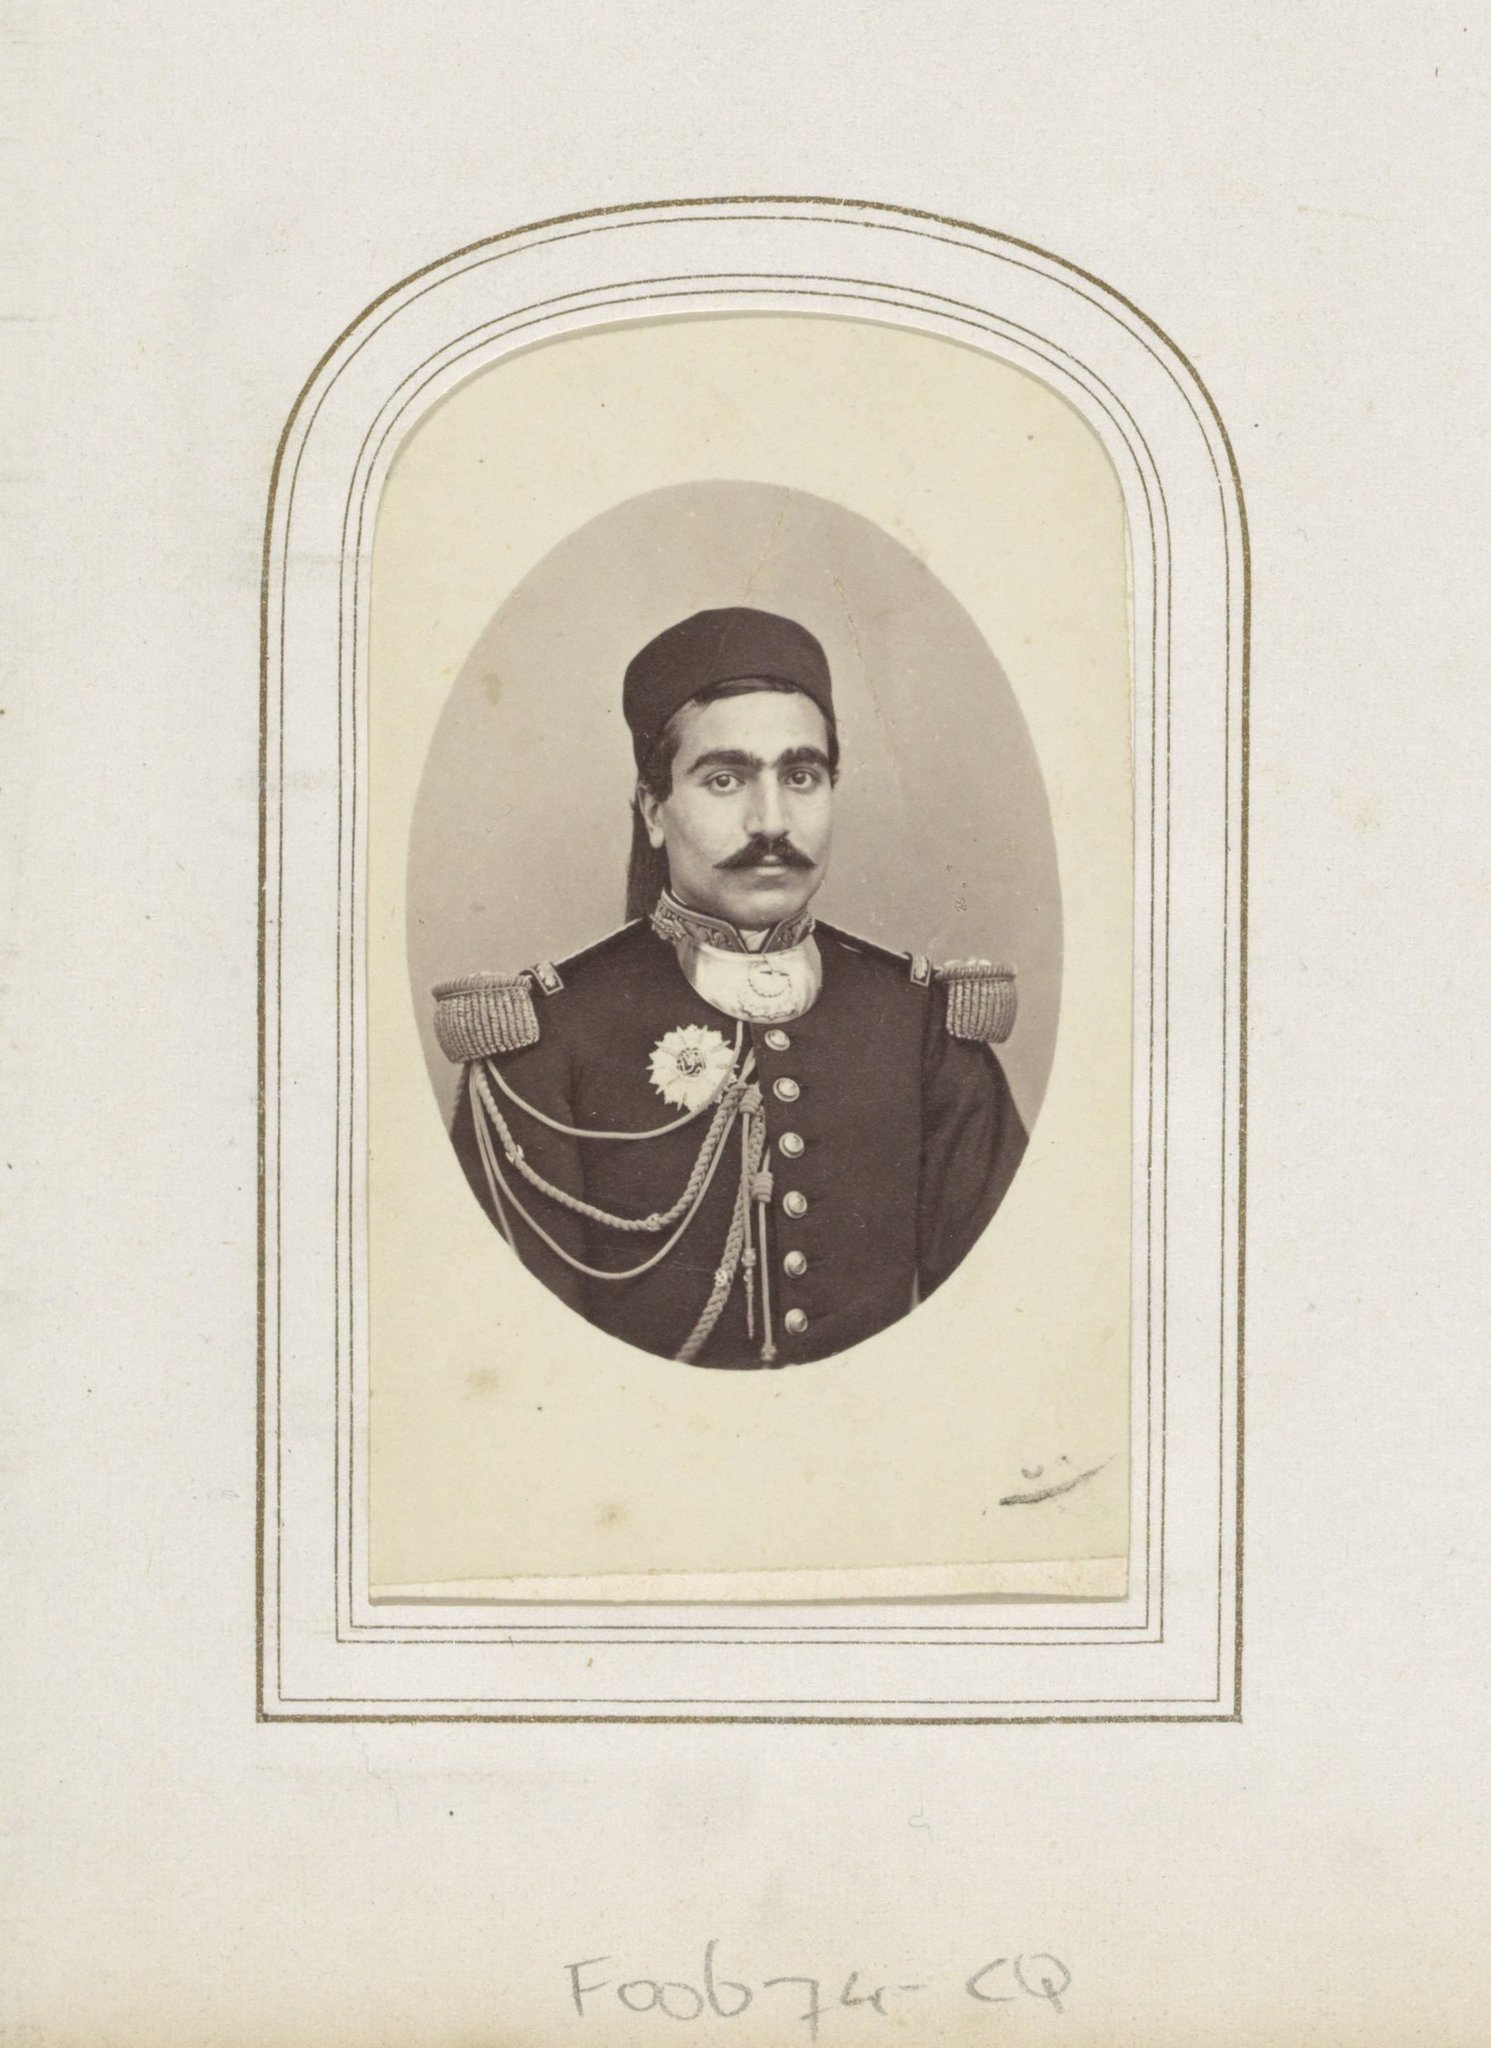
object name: carte de visite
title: Portret van Mustapha Ben Ismaïl, Tunesische generaal en minister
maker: Anonymous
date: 1875-1887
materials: cardboard, paper, photographic support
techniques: albumen print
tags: politician, minister ~ government, head-gear, moustache, historical persons, politician, e.g. party leader, officer, medals and other marks of military honour, (military) uniforms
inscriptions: inscription: ‘Le Général Moustapha Ben Ismail 1e [...] Camp de S.A. le Bey’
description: Onderdeel van Fotoalbum met 123 cartes-de-visite van leden van Europese vorstenhuizen, politici en bekende personen.